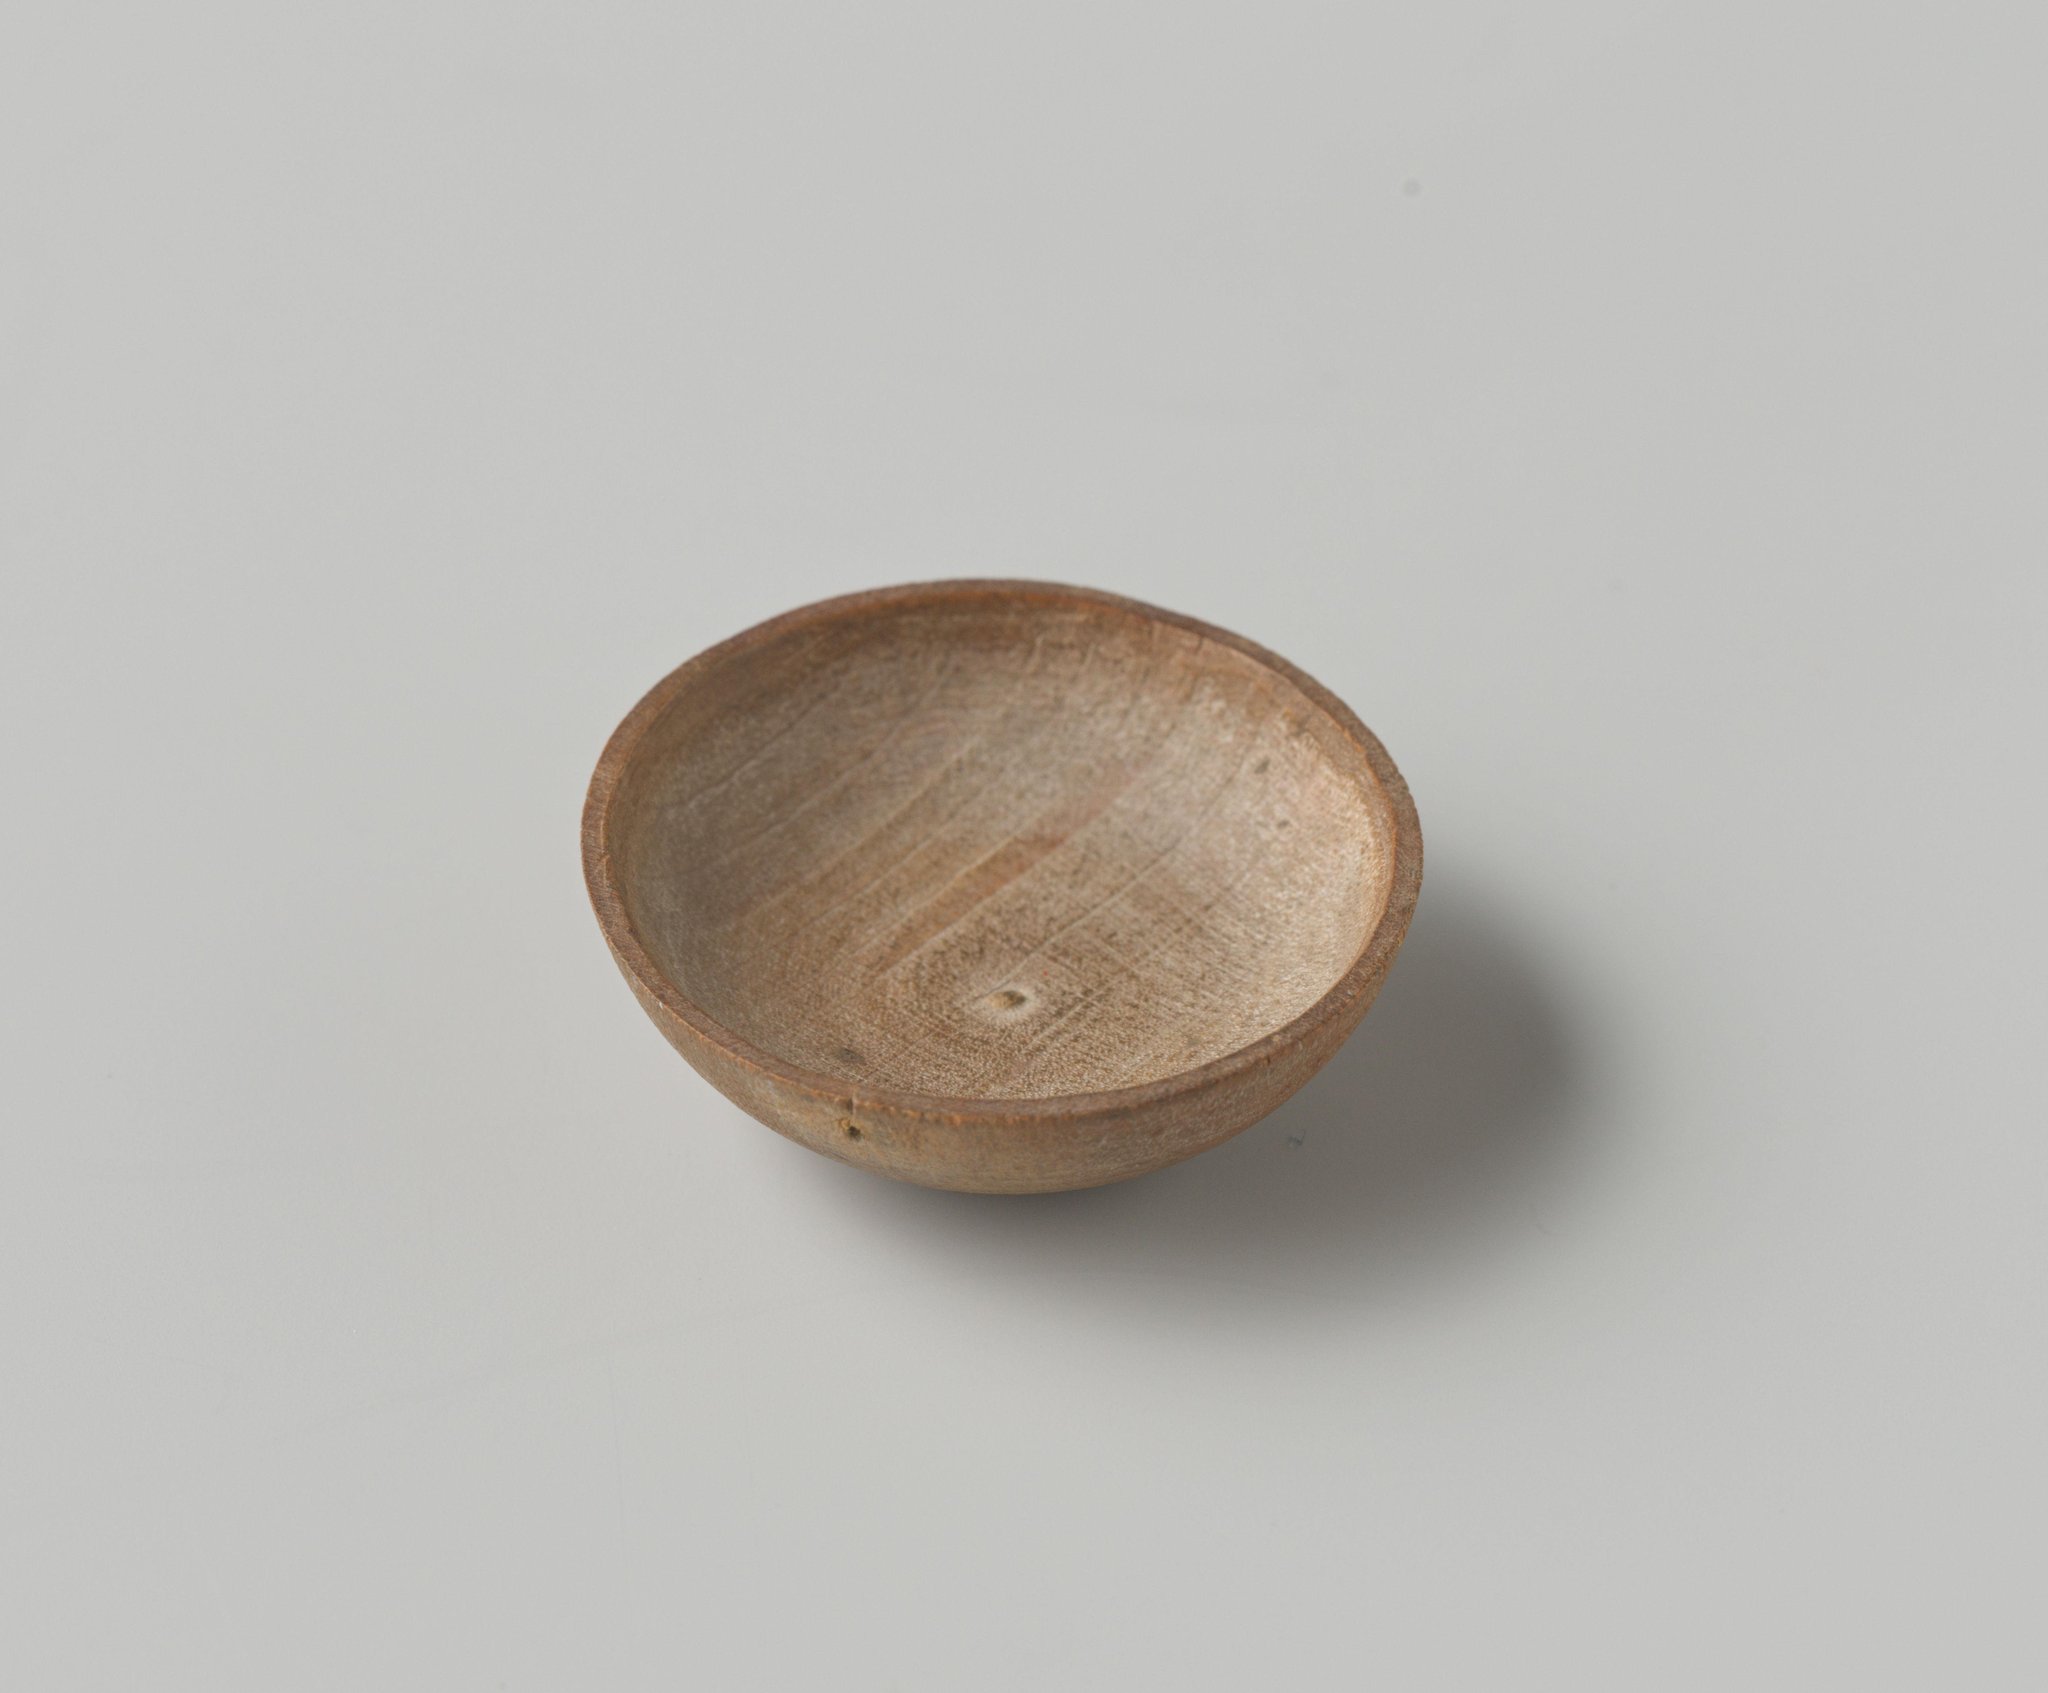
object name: bowl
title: Ronde kom gedraaid van esdoornhout; klein gaatje onder de rand voor koordje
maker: Anonymous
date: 1690-1710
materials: wood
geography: amsterdam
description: Ronde kom gedraaid van esdoornhout; klein gaatje onder de rand voor koordje.